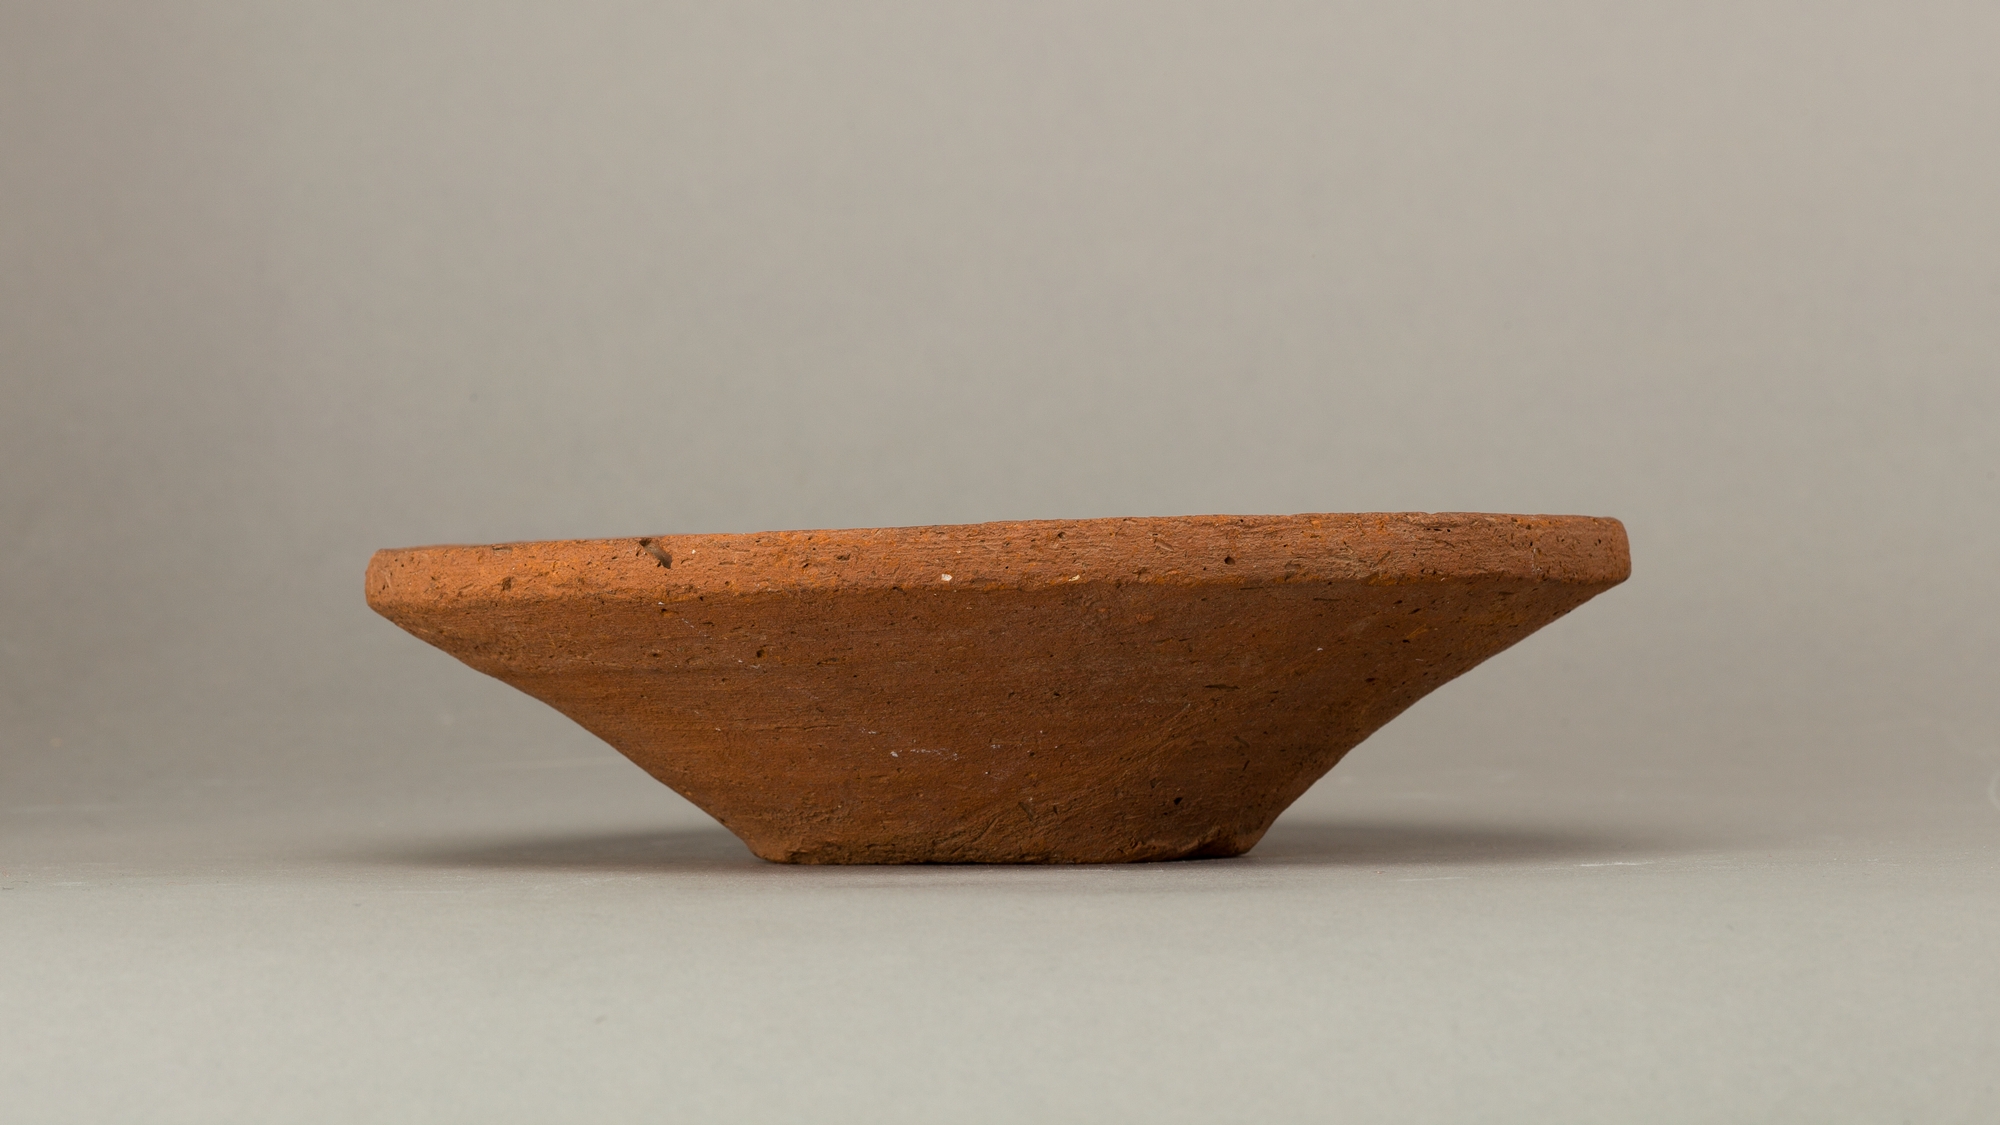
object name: bowl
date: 2649-2100 BCE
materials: pottery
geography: egypt